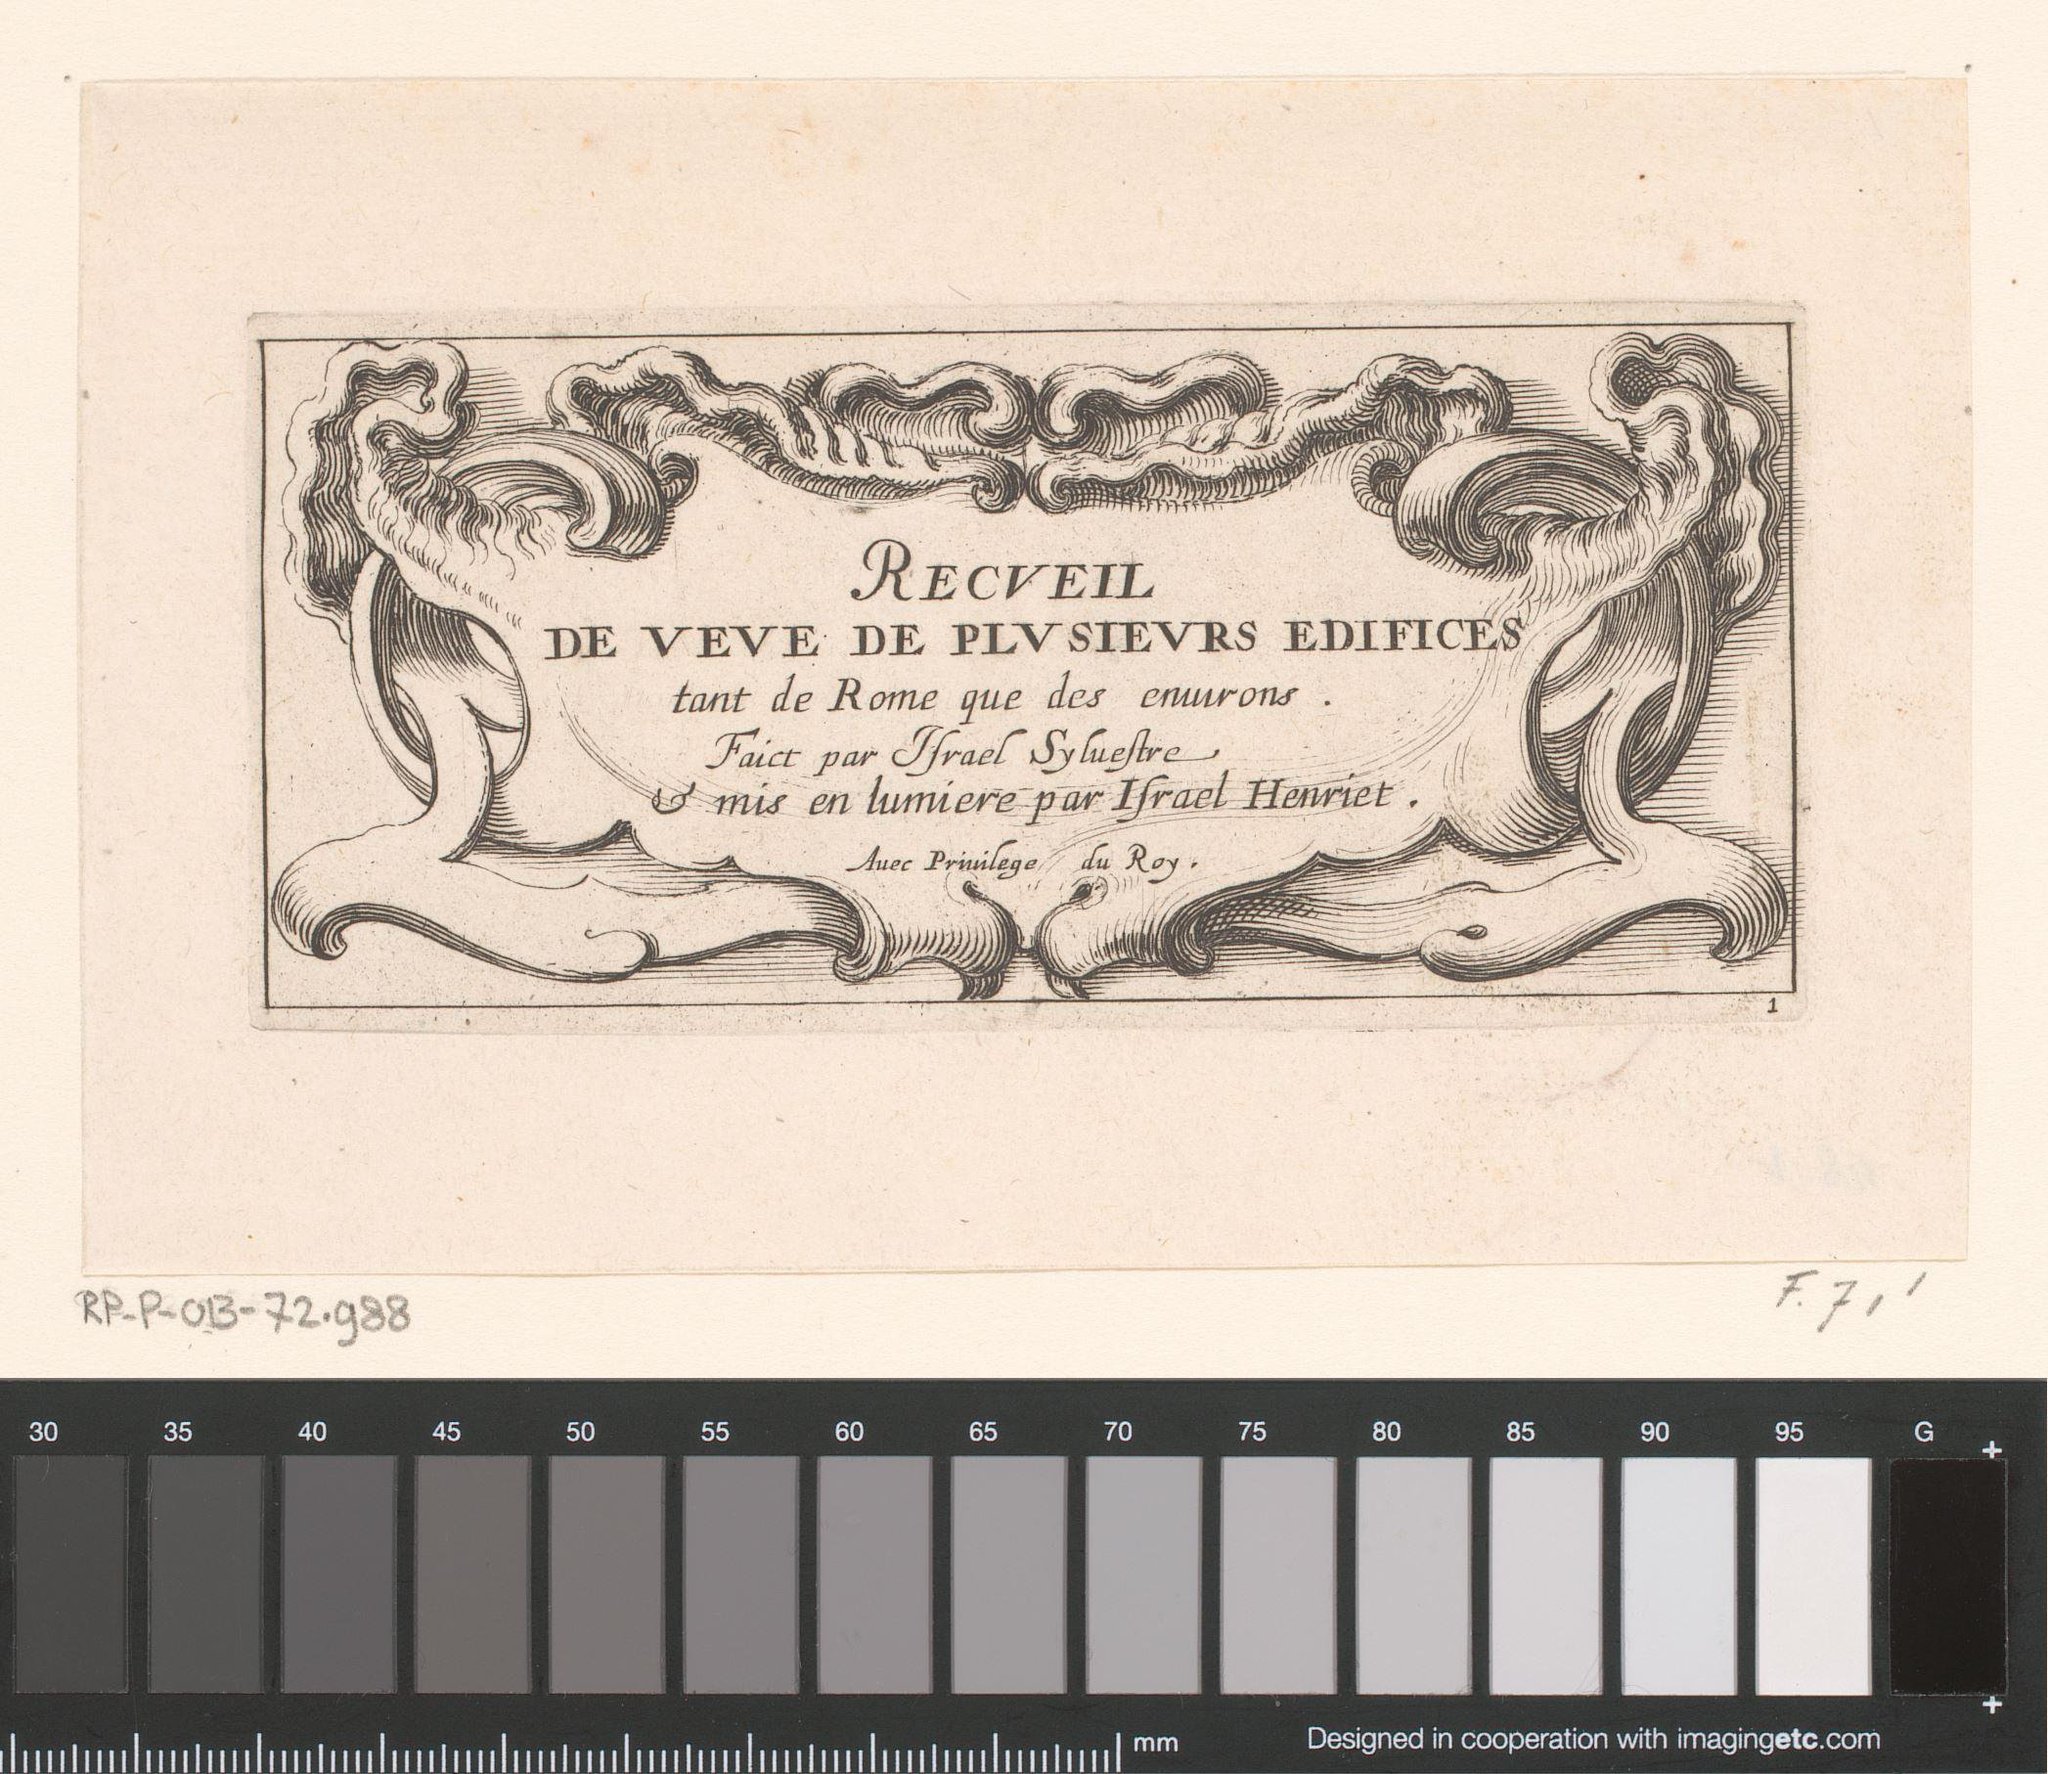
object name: titelprent, frontispice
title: Titelprent met cartouche met kwabornament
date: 1636-1661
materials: paper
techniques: etching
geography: france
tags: auricular ornament, lobe style ~ ornament, ornament ~ cartouche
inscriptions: collector's mark: Lugt 240